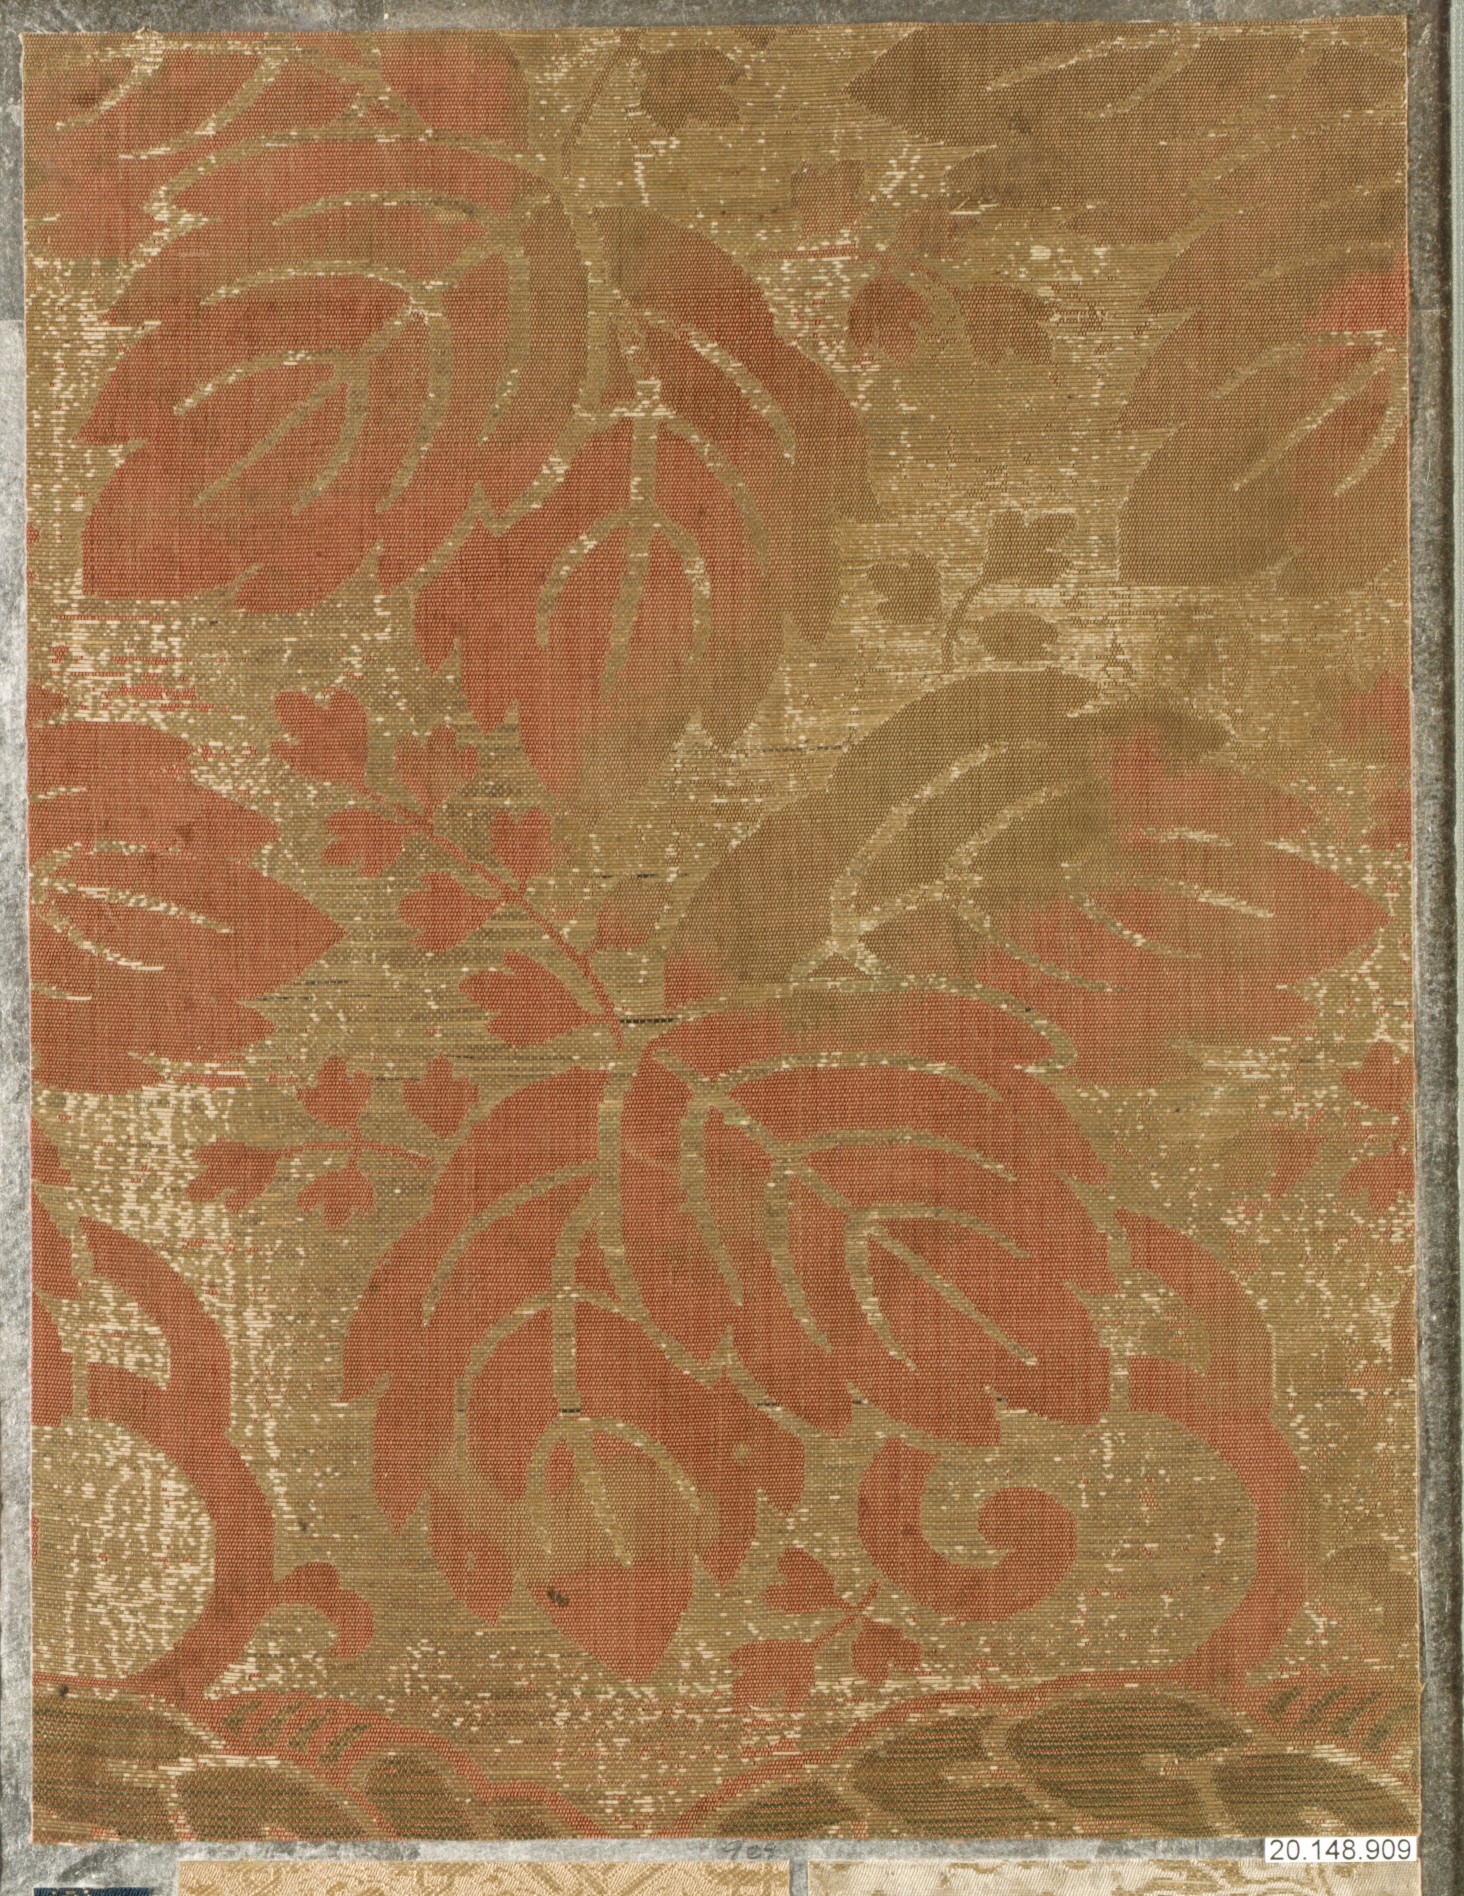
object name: piece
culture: japanese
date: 1601-1700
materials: silk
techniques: compound weave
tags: leaves